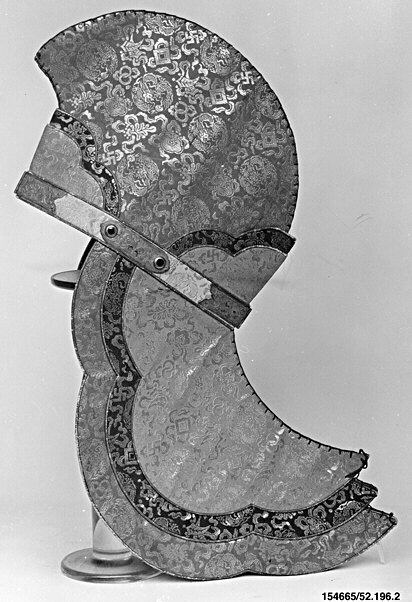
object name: hat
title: Phoenix Hat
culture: japanese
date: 1801-1833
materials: gold thread, metal, silk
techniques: compound weave, engraving